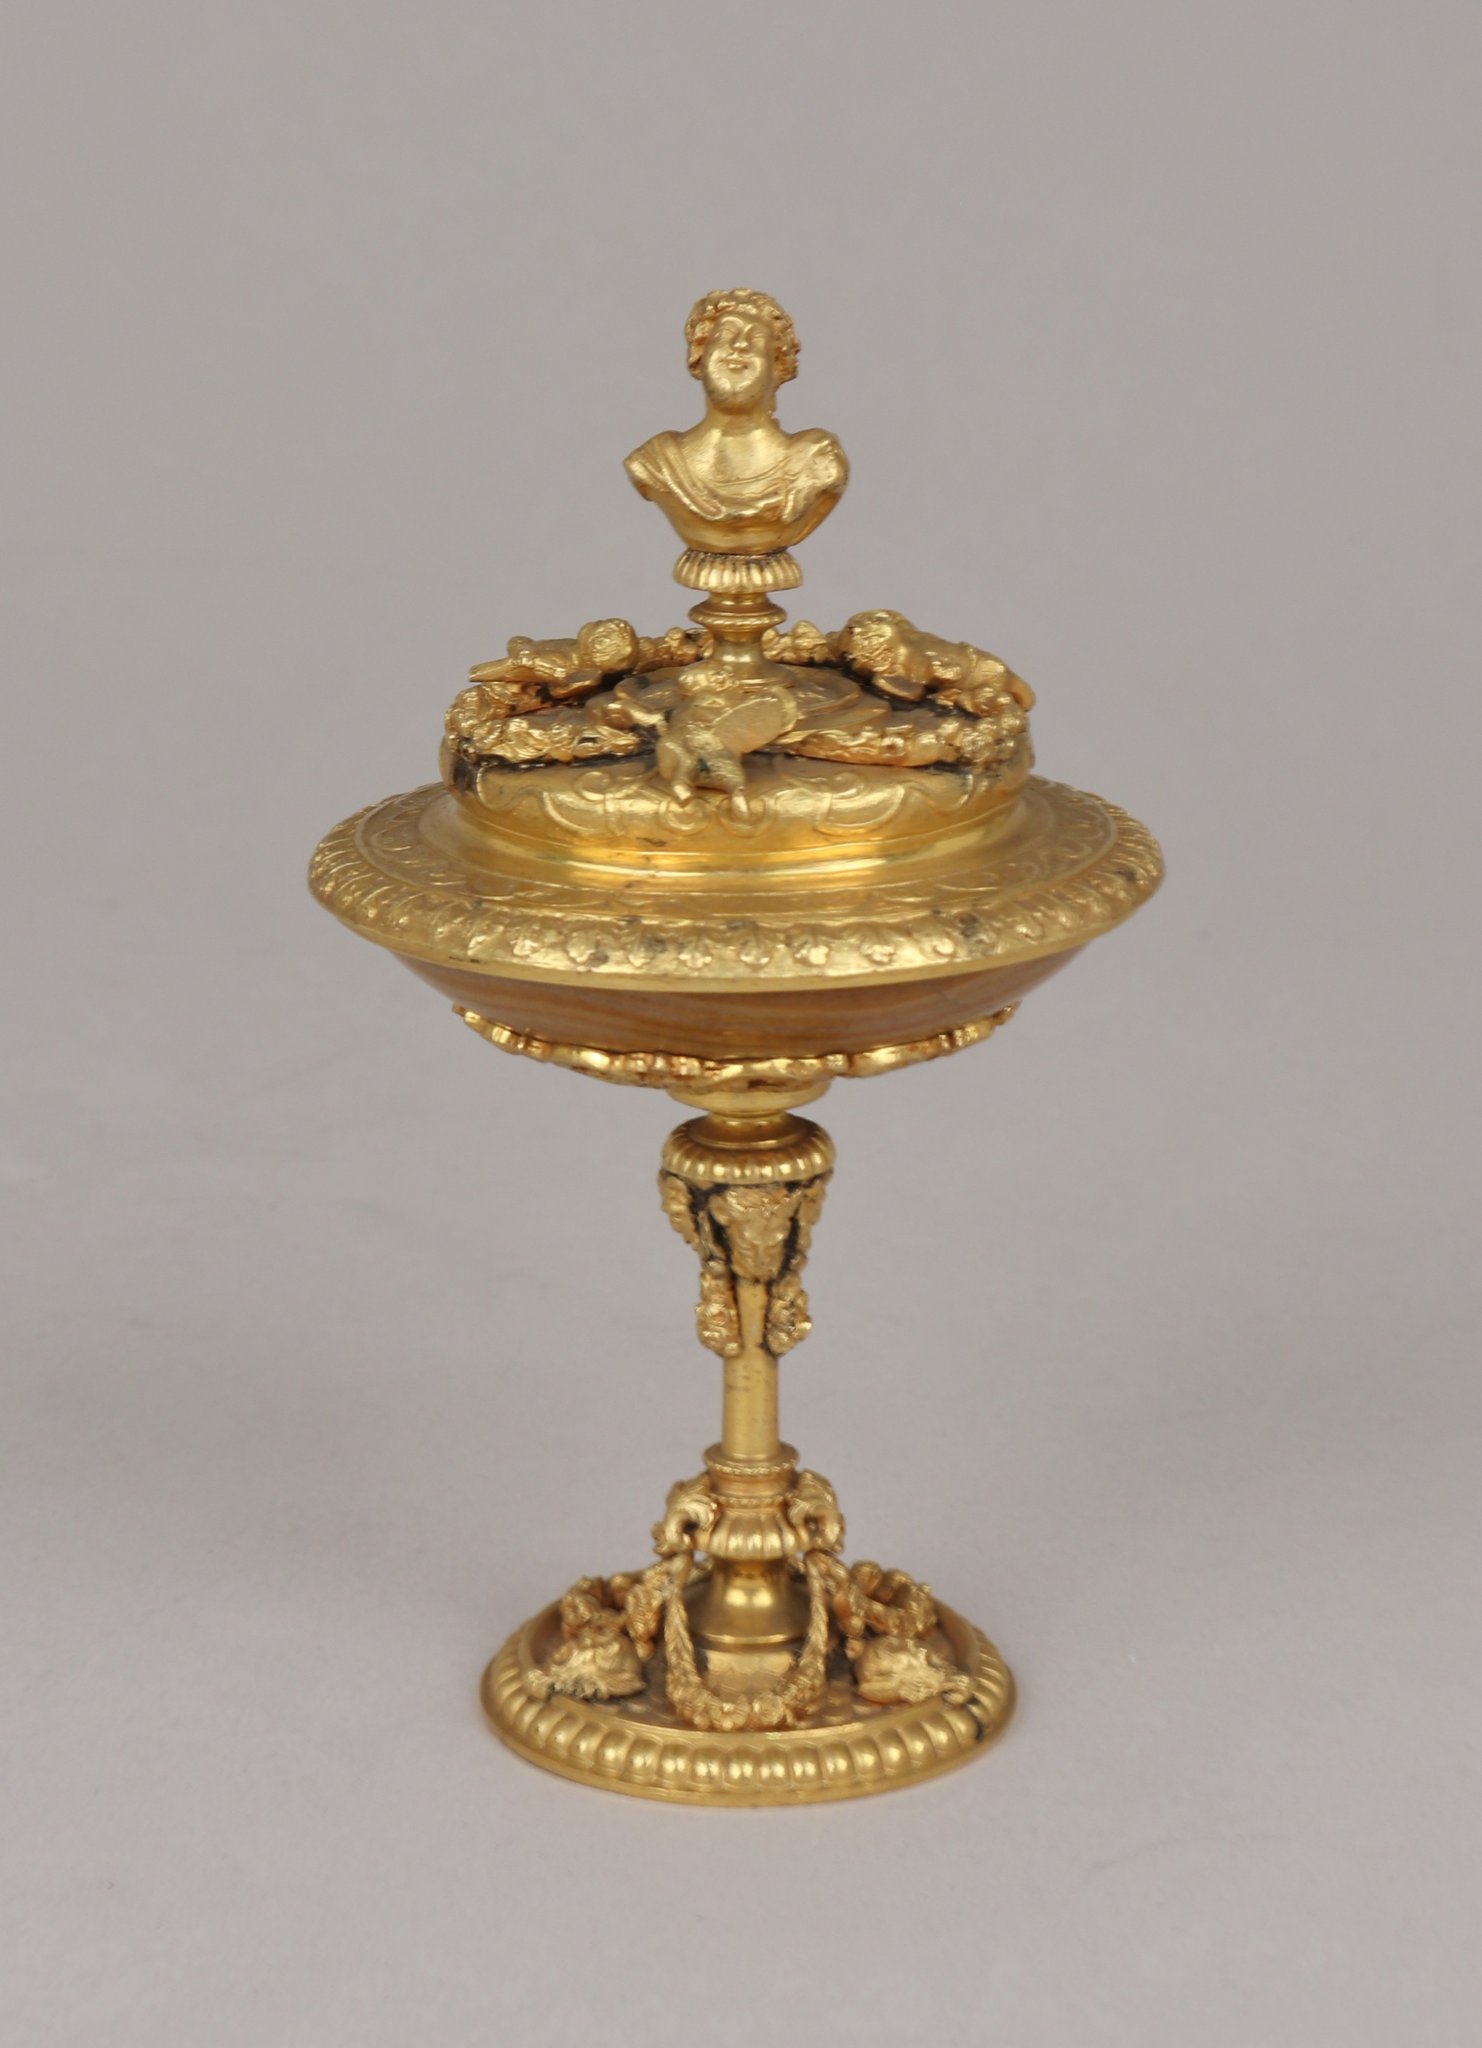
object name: tazza with cover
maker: benvenuto cellini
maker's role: maker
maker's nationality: italian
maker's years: 1500-1571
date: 1801-1900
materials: stone, gold